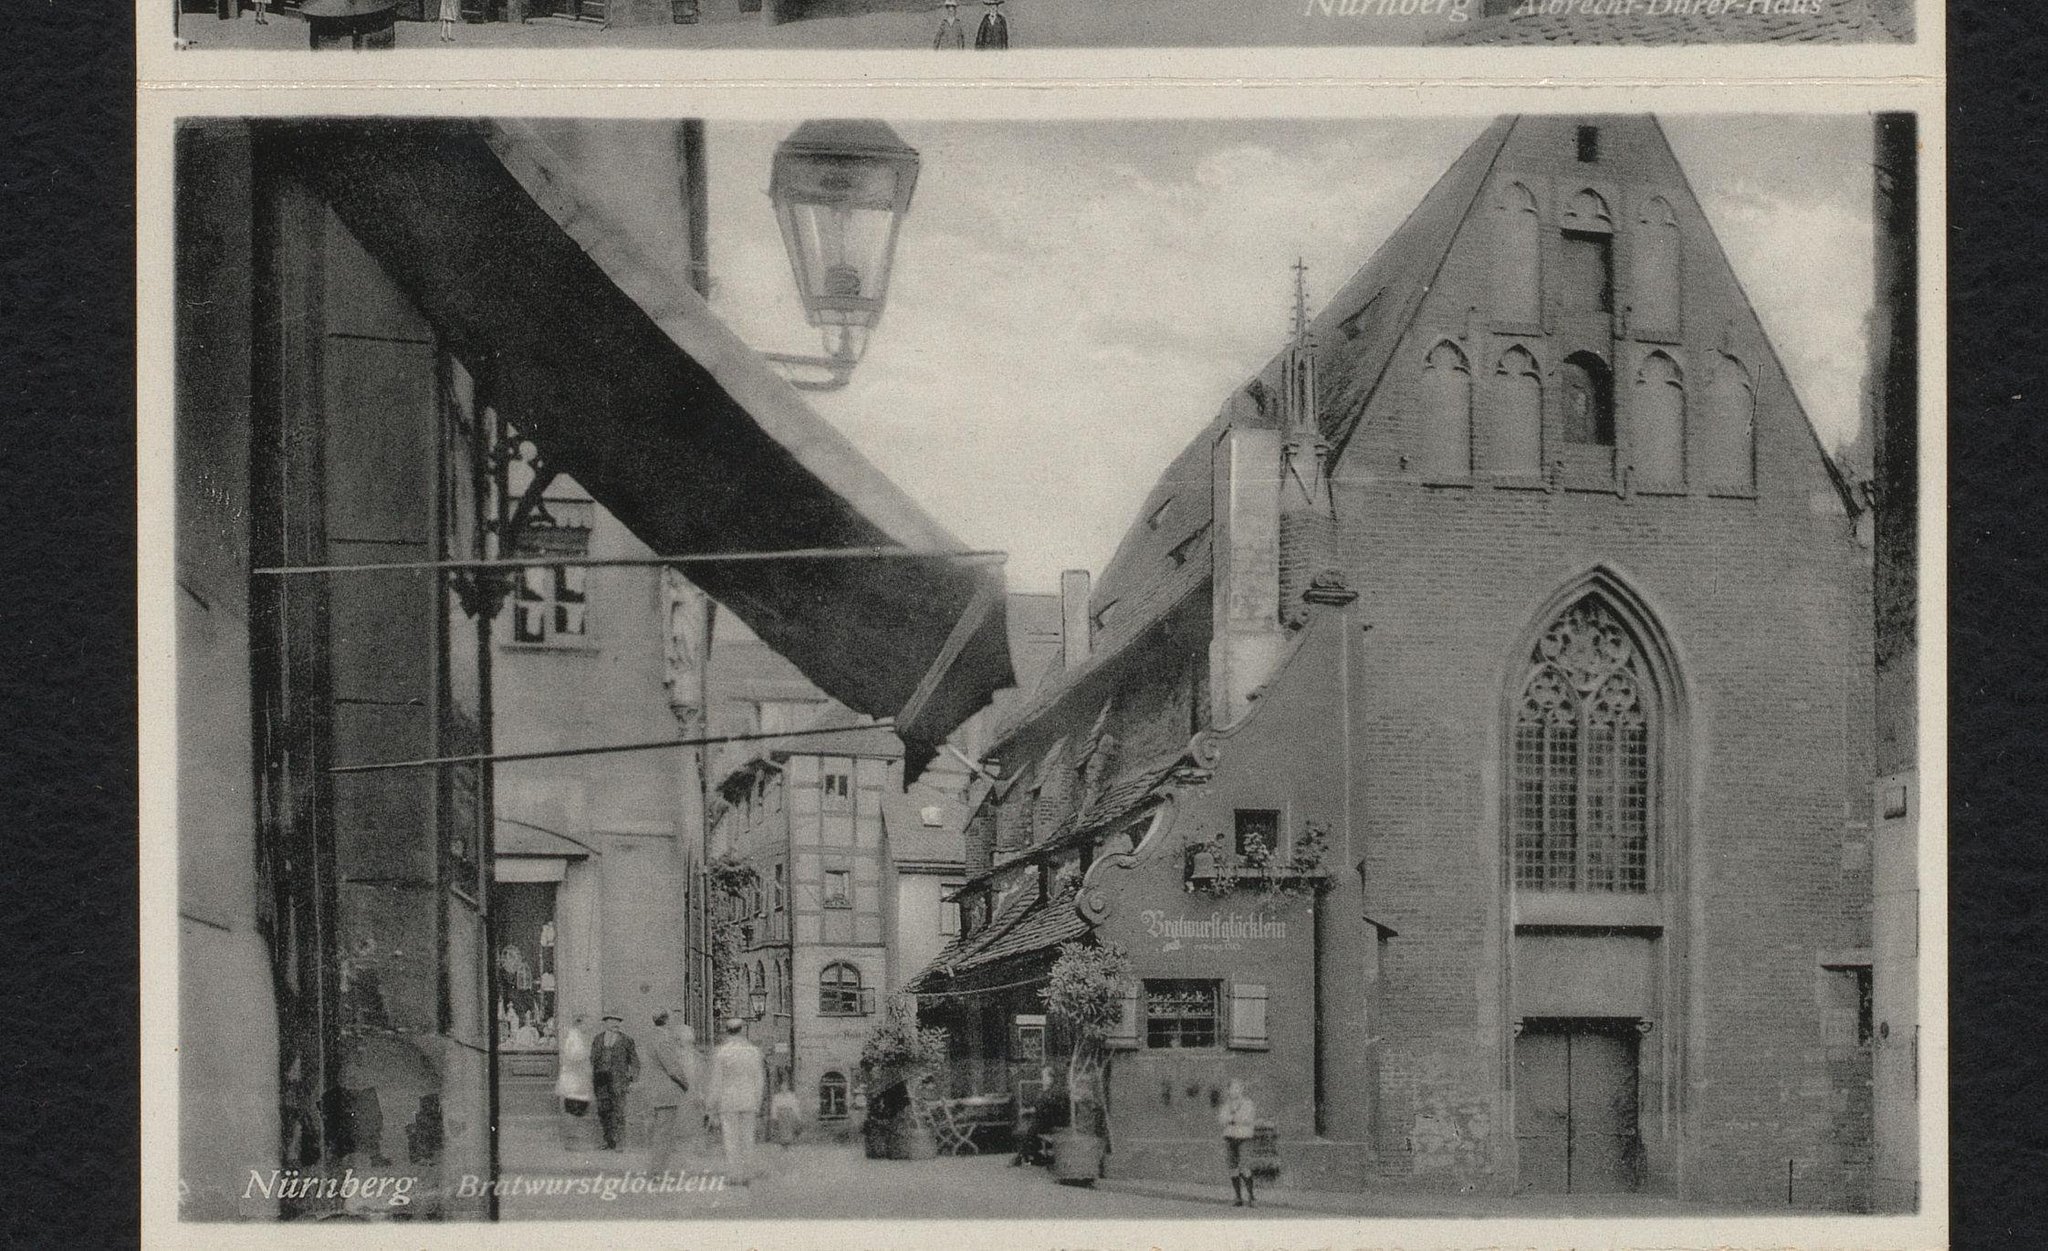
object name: ansichtkaart, prentbriefkaart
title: Nürnberg. Karlsbrücke mit Schleifersteg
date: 1905-1944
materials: cardboard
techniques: photograph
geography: darmstadt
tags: canals, waters (in village), bridge in village across river, canal, etc.